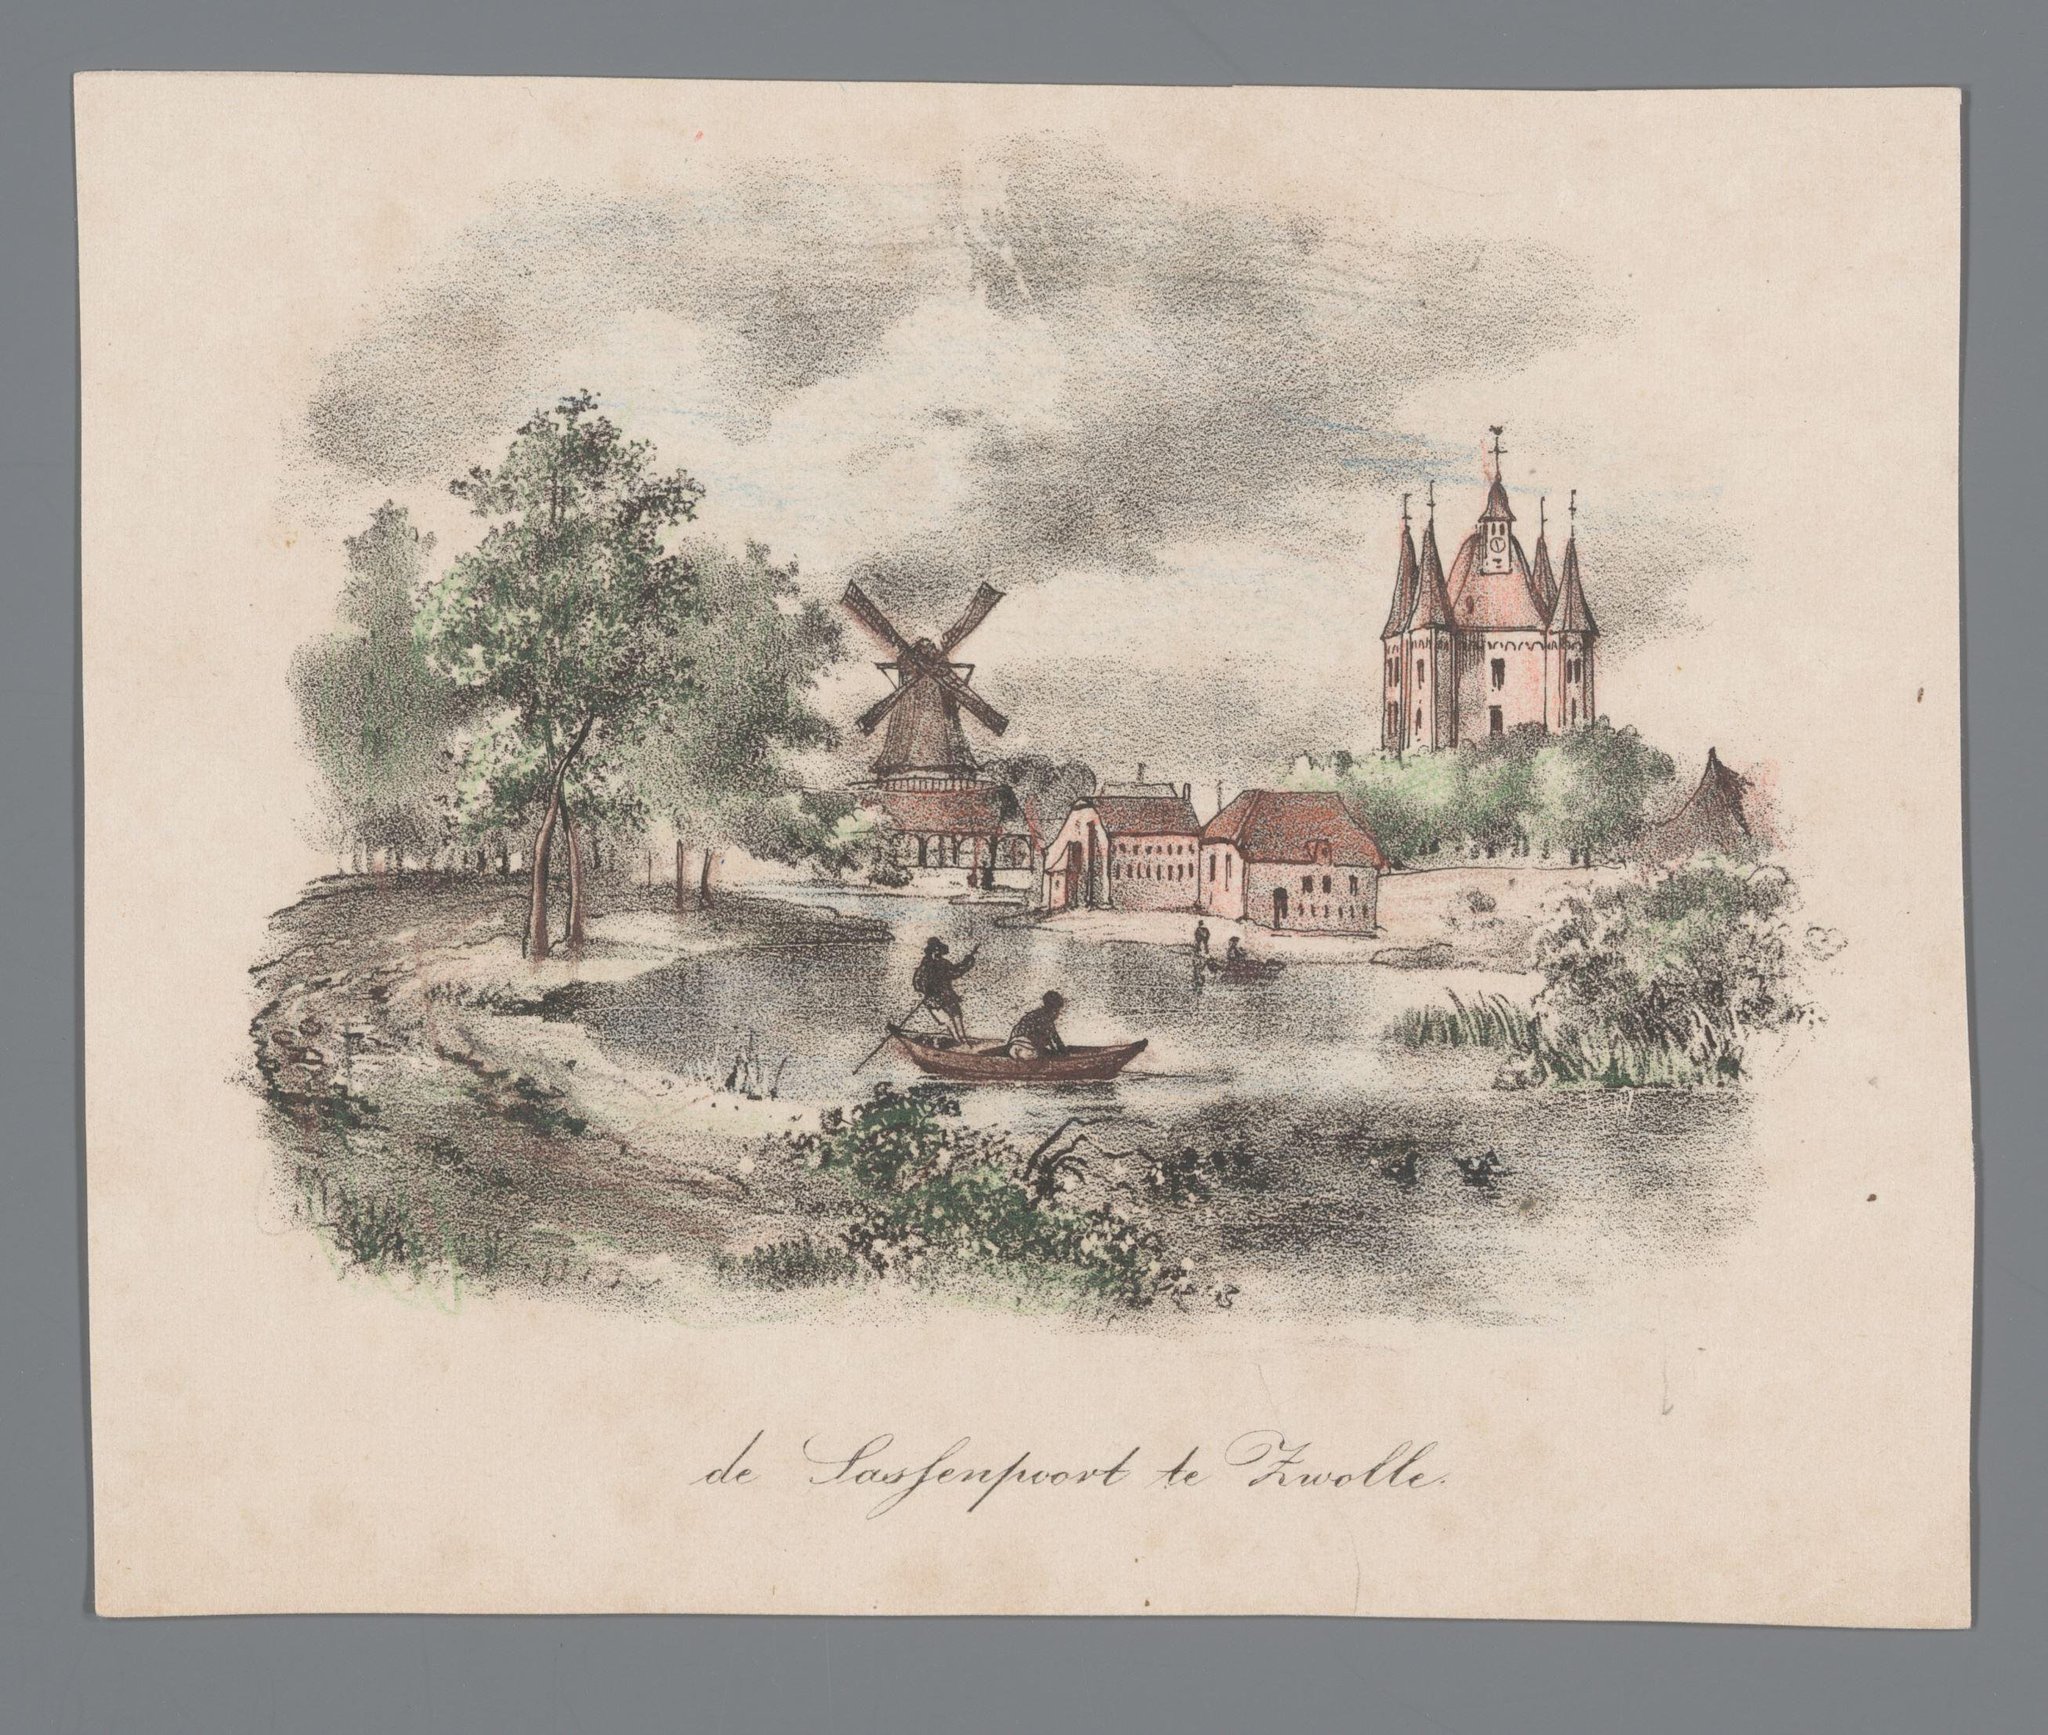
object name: print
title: Gezicht op de Sassenpoort te Zwolle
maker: Anonymous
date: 1820-1870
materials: paper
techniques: hand coloring, lithograph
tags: windmill in landscape, city-gate, canals, waters (in city) (+ city(-scape) with figures, staffage)